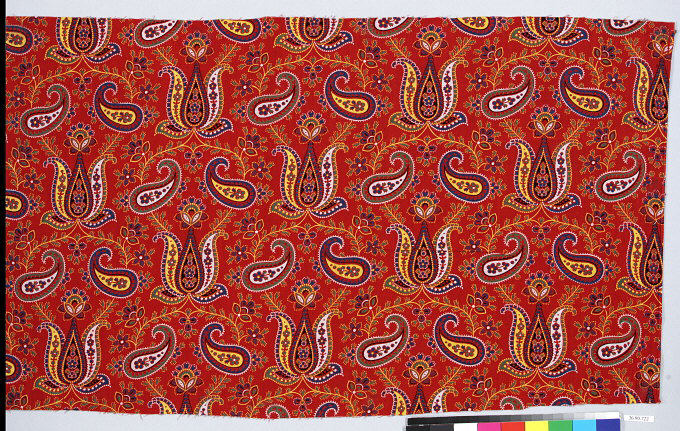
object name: piece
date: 1867-1900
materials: cotton